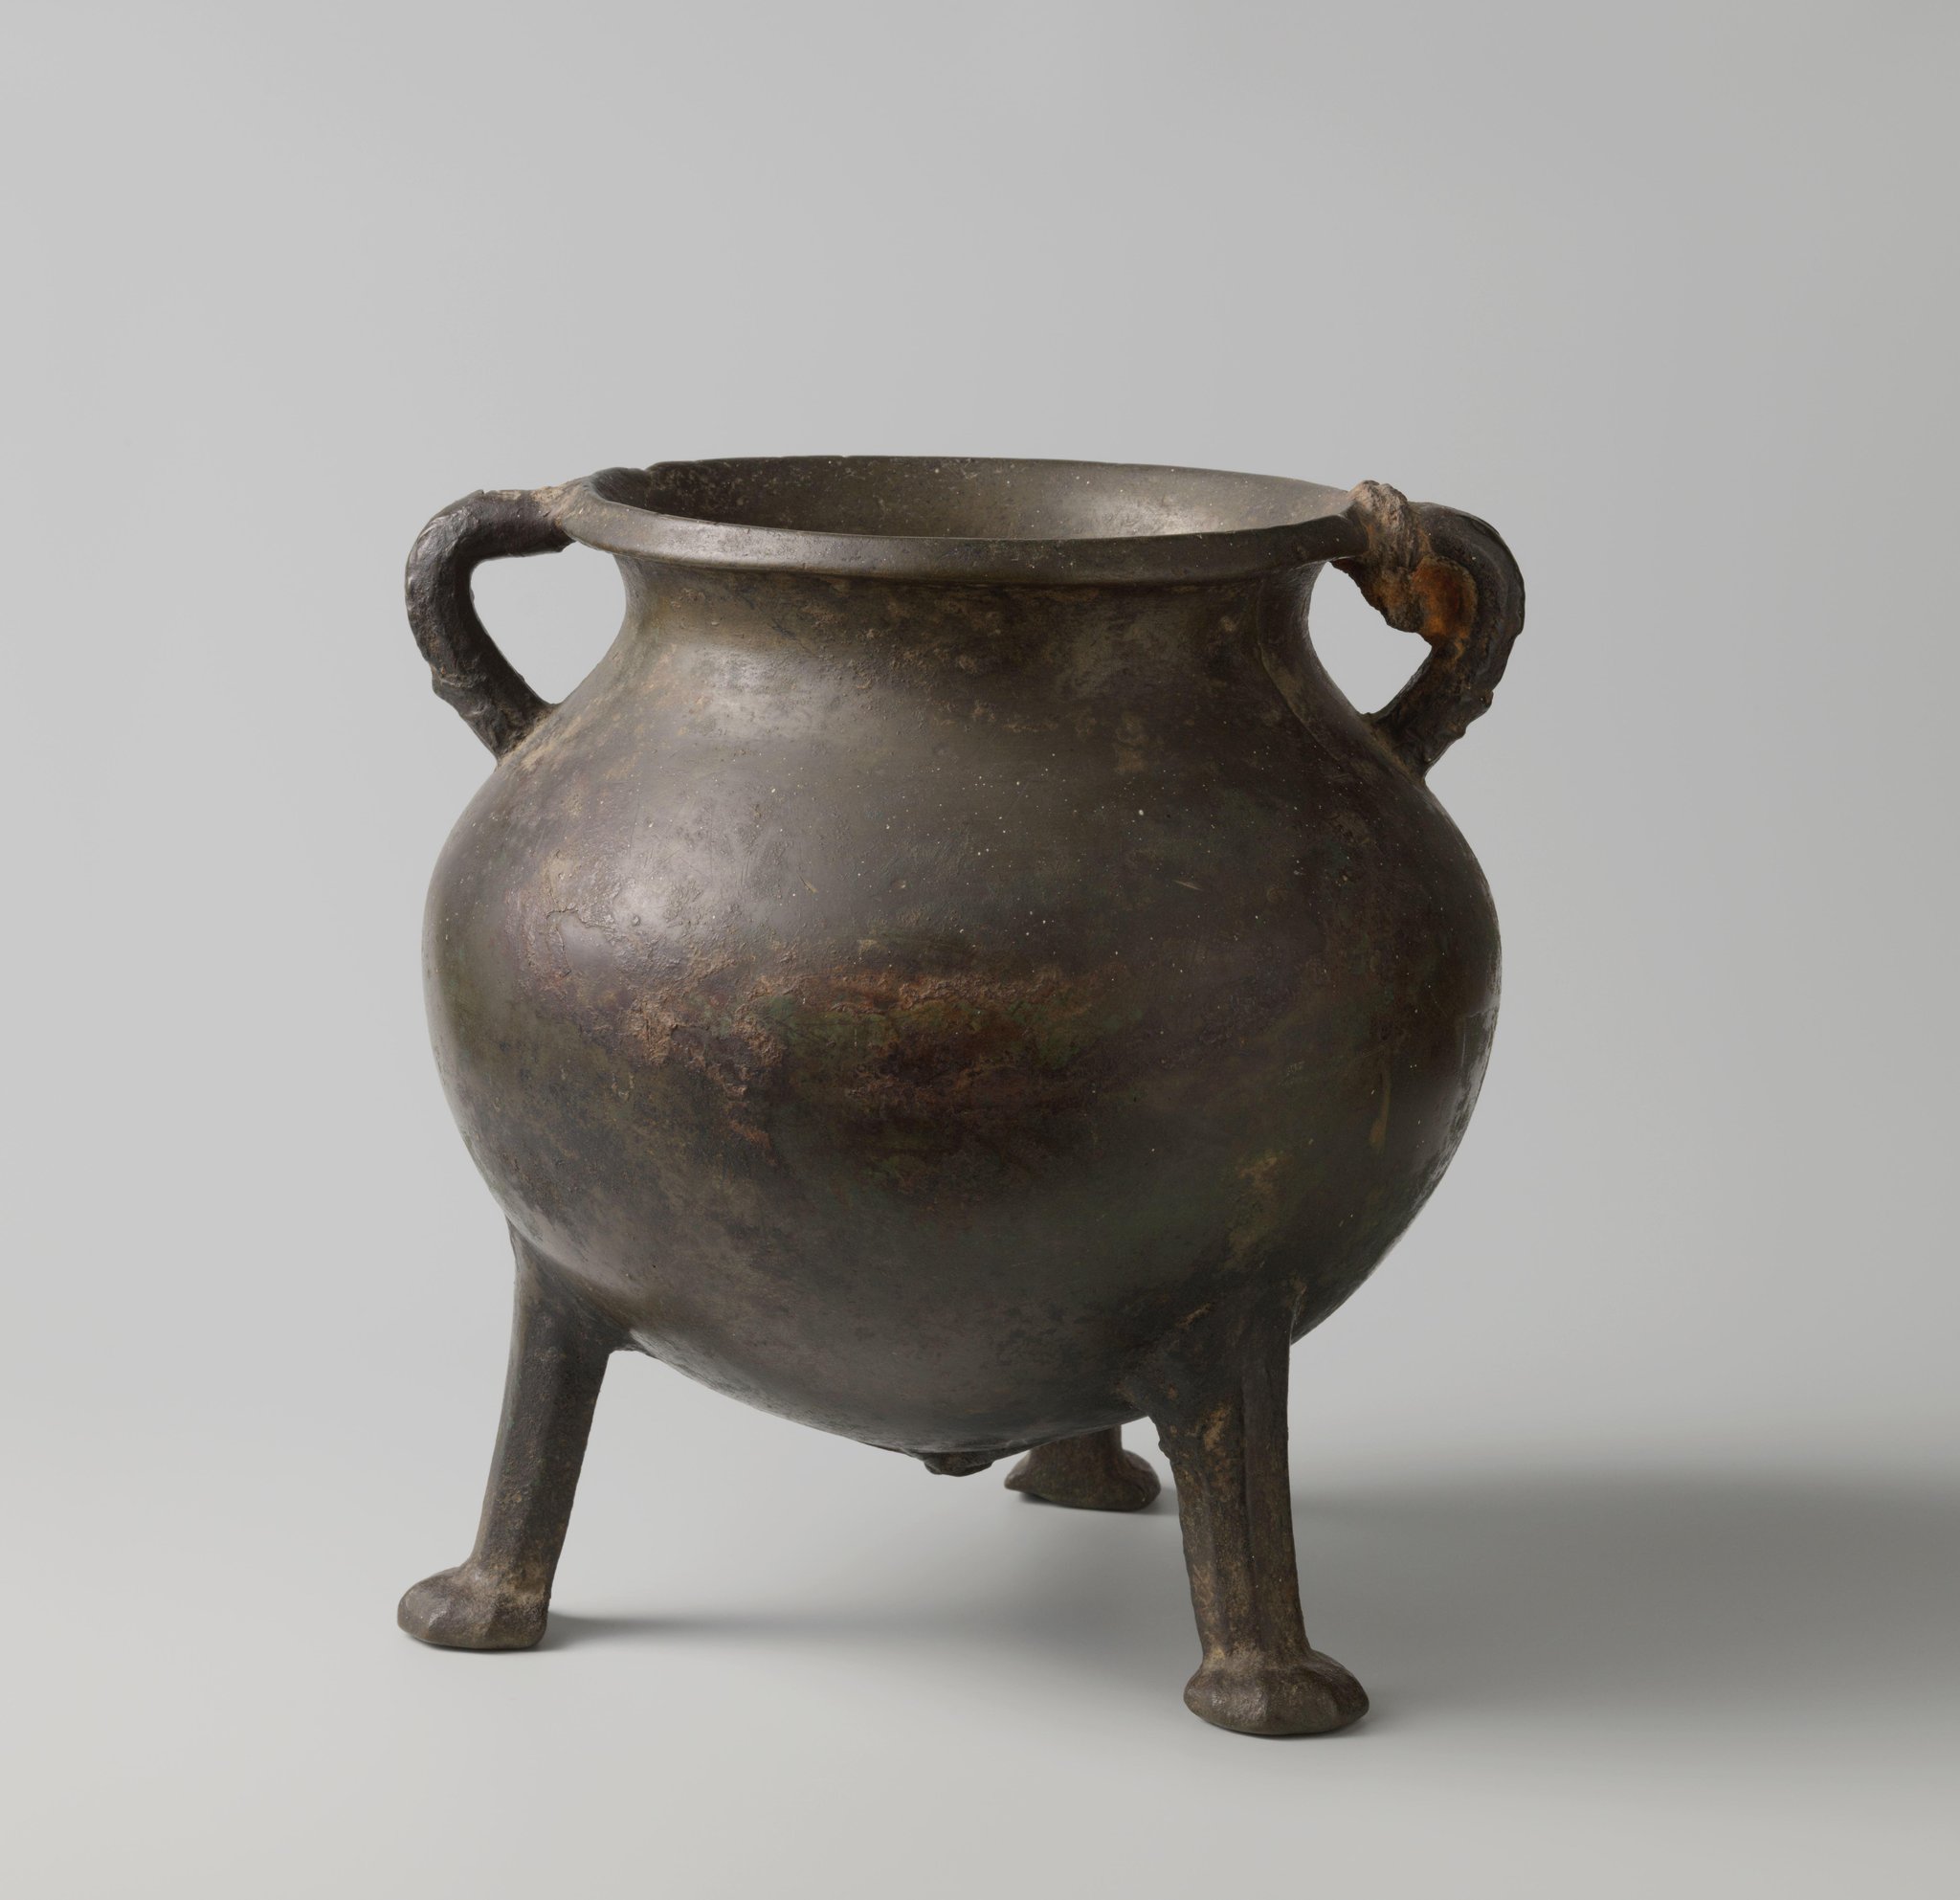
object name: cauldron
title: Kookpot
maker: Anonymous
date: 1200-1300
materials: bronze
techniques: brazing, casting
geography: northern netherlands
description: Kookpot van brons. De romp heeft een gietnaad nabij de oren en is kogelvormig, doch iets uitgezakt. Hij heeft onderaan een verdikking, die ten gevolge van de giettechniek is ontstaan. Deze wordt gevormd door een rond gietgat met twee keer drie straalsgewijs geplaatste gietribben. De overgang van romp naar hals is vloeiend. De liprand heeft bovenaan een betrekkelijk scherpe kant en loopt naar buiten schuin uit. De pot staat op drie zeszijdige poten, waarvan de binnenste zijde de gehele breedte inneemt. Deze lijken later aangezet. Zij lopen uit in zevenzijdige voeten, waarvan de binnenste zijde eveneens de gehele breedte inneemt. De in elkaars verlengde liggende oren zijn waarschijnlijk later aangezet. Ze zijn afgerond scherphoekig en in doorsnede veelzijdig. Aan de buitenkanten hebben zij een vaag ornament, bestaande uit een slingerende rank met teruggeslagen bladeren. Bij de aanzet van één der oren bevindt zich een stuk ijzer, dat oorspronkelijk behoord heeft tot het hengsel.